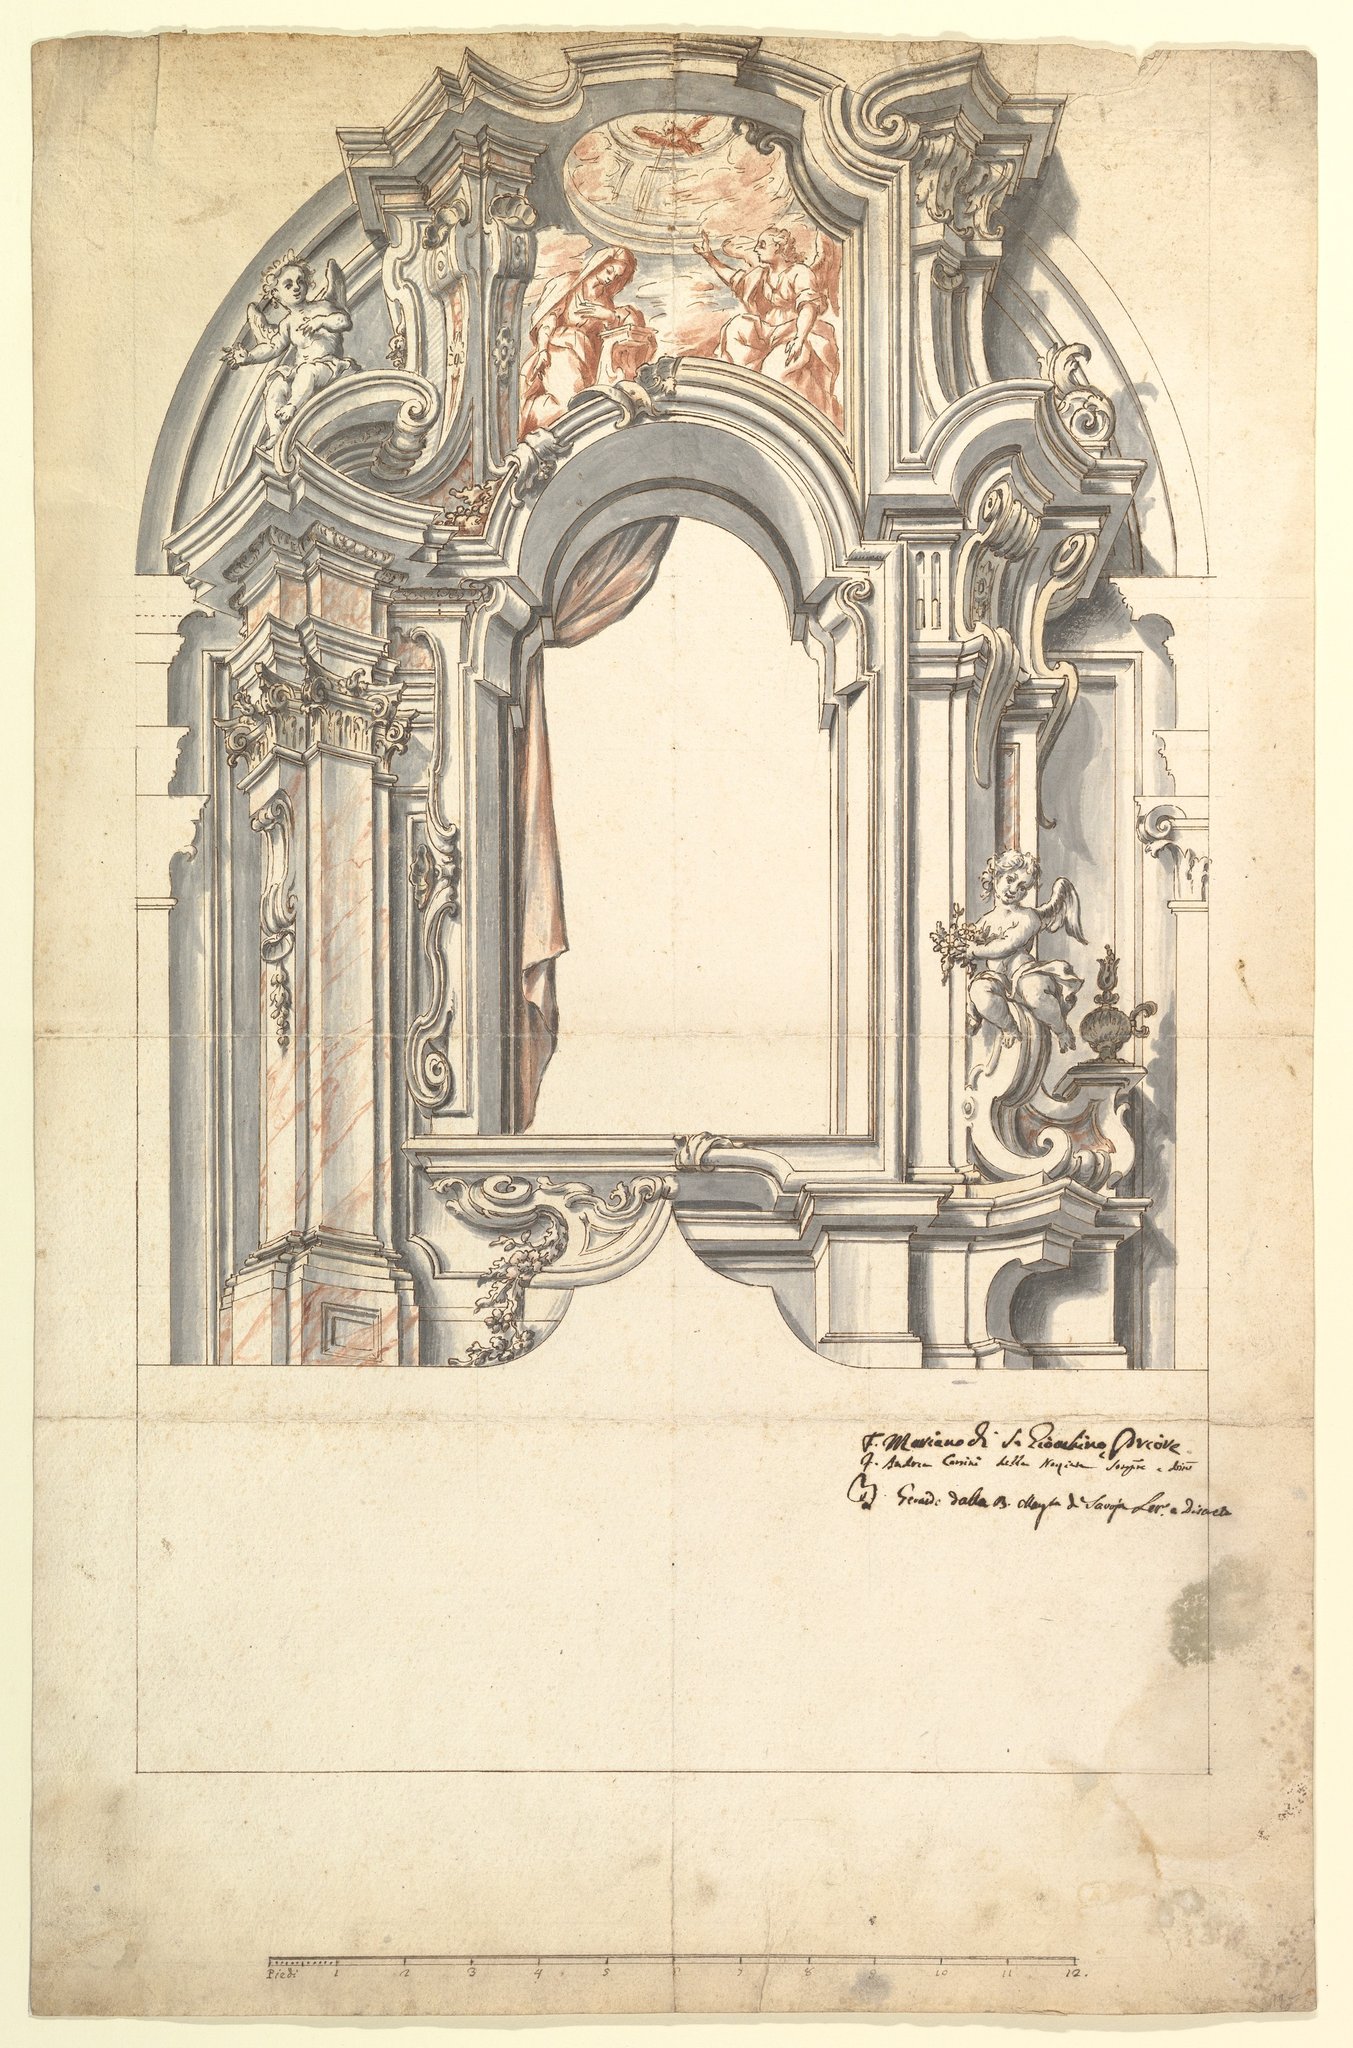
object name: drawing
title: Two Alternate Designs for an Altar (?)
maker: anonymous, italian, piedmontese, 18th century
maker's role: artist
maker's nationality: italian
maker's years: 1700-1800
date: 1700-1780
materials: chalk, graphite, ink, drawing material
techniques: brush, pen, wash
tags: altars